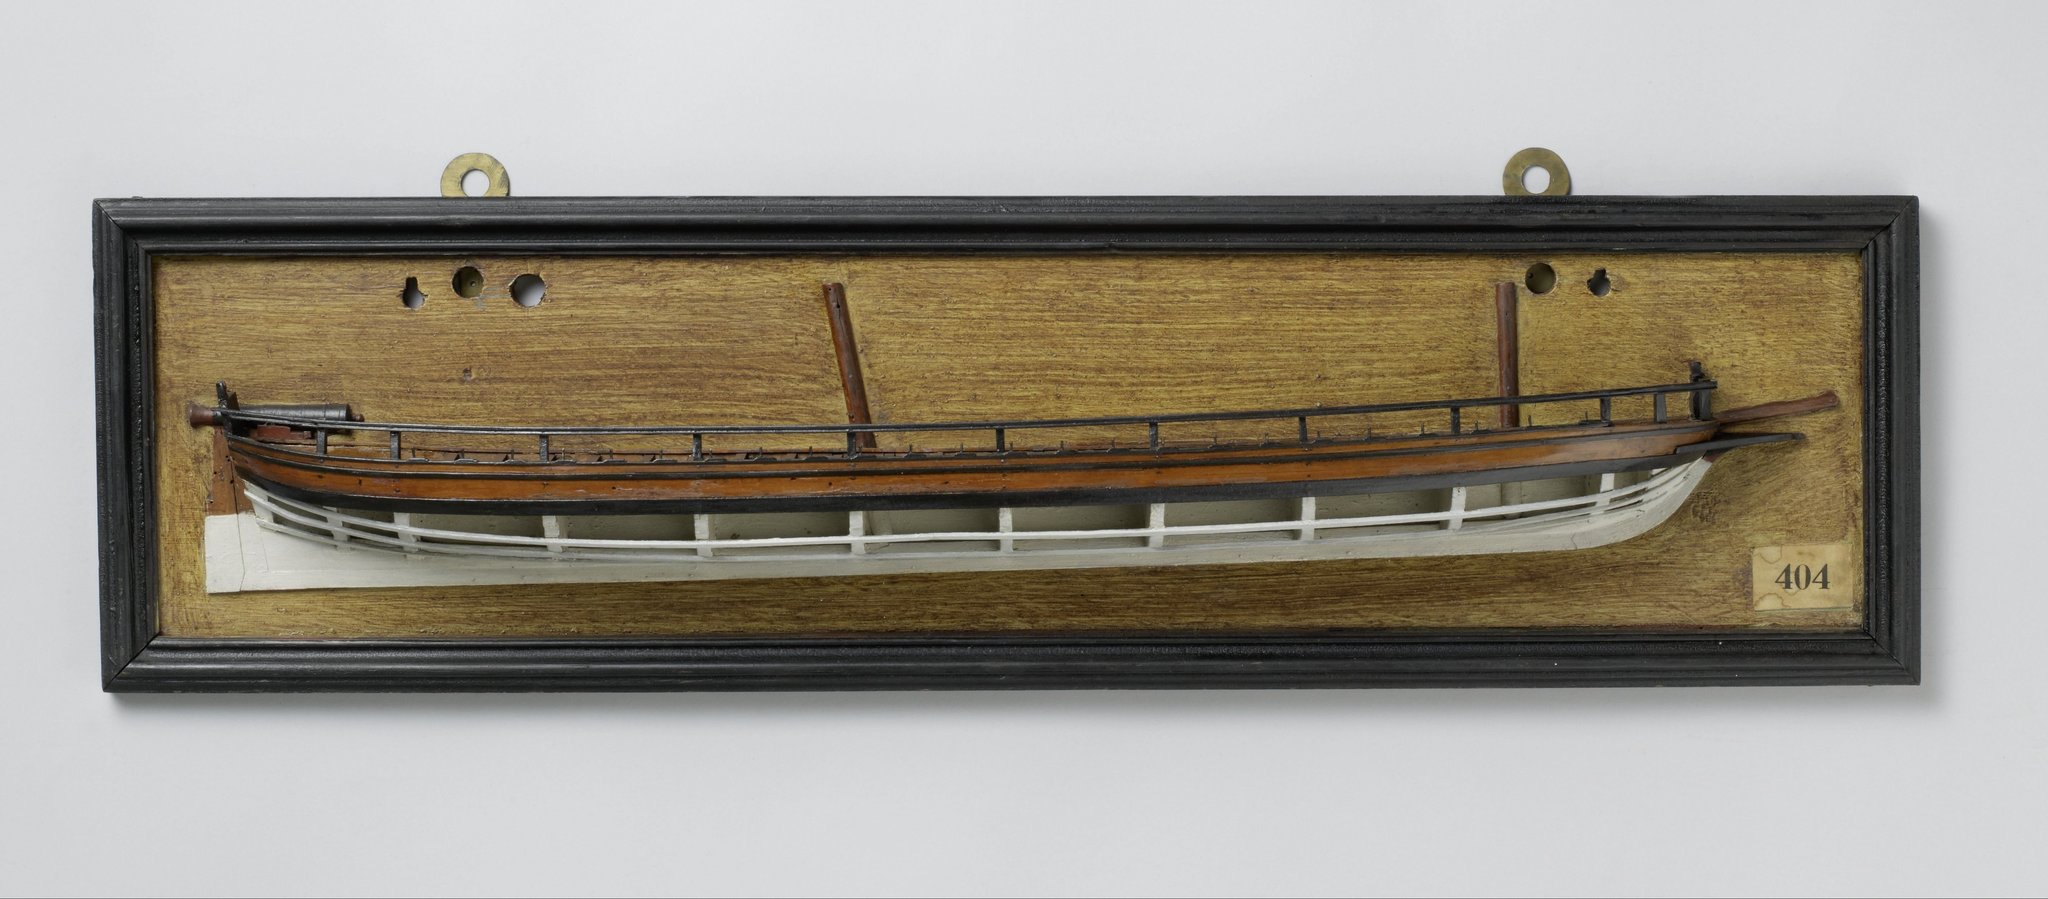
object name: ship model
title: Half model of a two or three-gun gunboat schooner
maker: Anonymous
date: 1803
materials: wood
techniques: polychromy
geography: netherlands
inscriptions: label, bottom right: ‘404’ former inventory label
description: De kanonneerschoener lijkt erg op de zogenaamde kanonneergaleien.